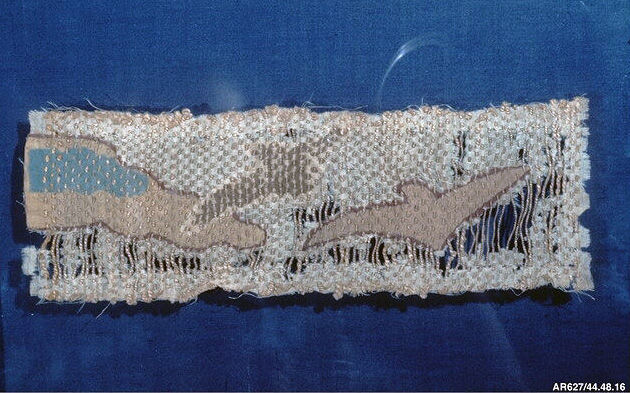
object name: fragment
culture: japanese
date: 701-800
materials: metal, silk